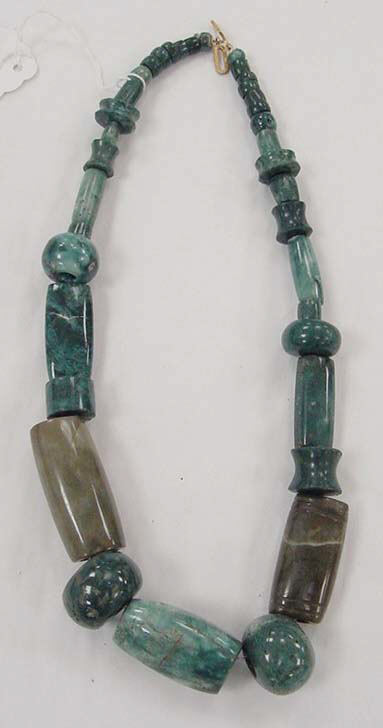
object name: necklace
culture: indigenous american or costa rican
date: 500 BCE-900 CE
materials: jade